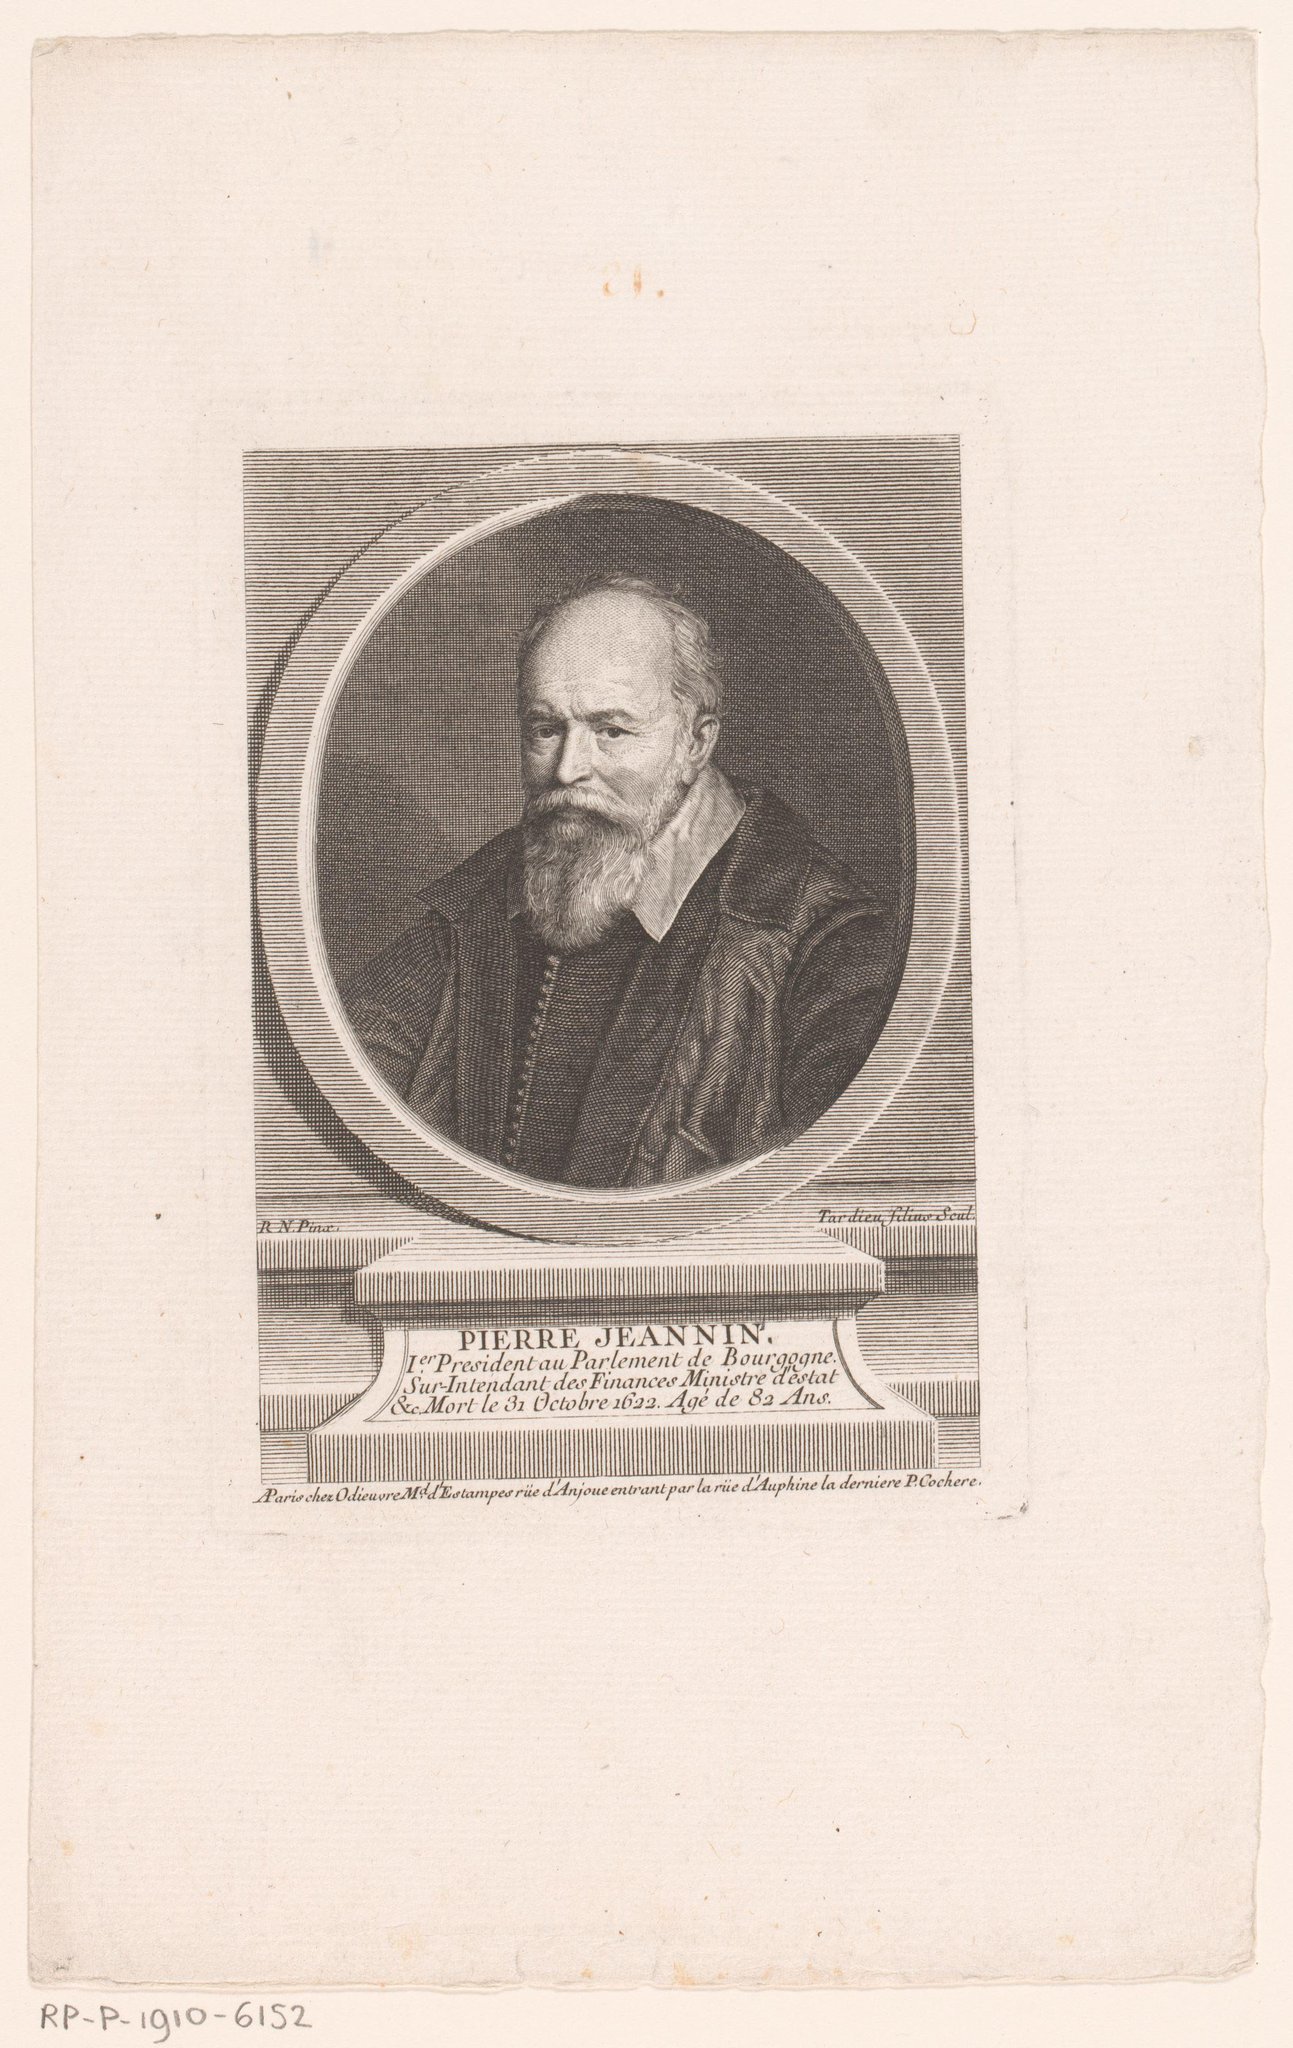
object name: print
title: Portret van Pierre Jeannin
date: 1755-1765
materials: paper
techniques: engraving, etching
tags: paris, historical persons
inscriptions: collector's mark: Lugt 2228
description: Prent als illustratie gebruikt voor het boek: Dreux de Radier, Jean François. L'Europe illustre. Parijs: Michel Odieuvre, 1755-1765.